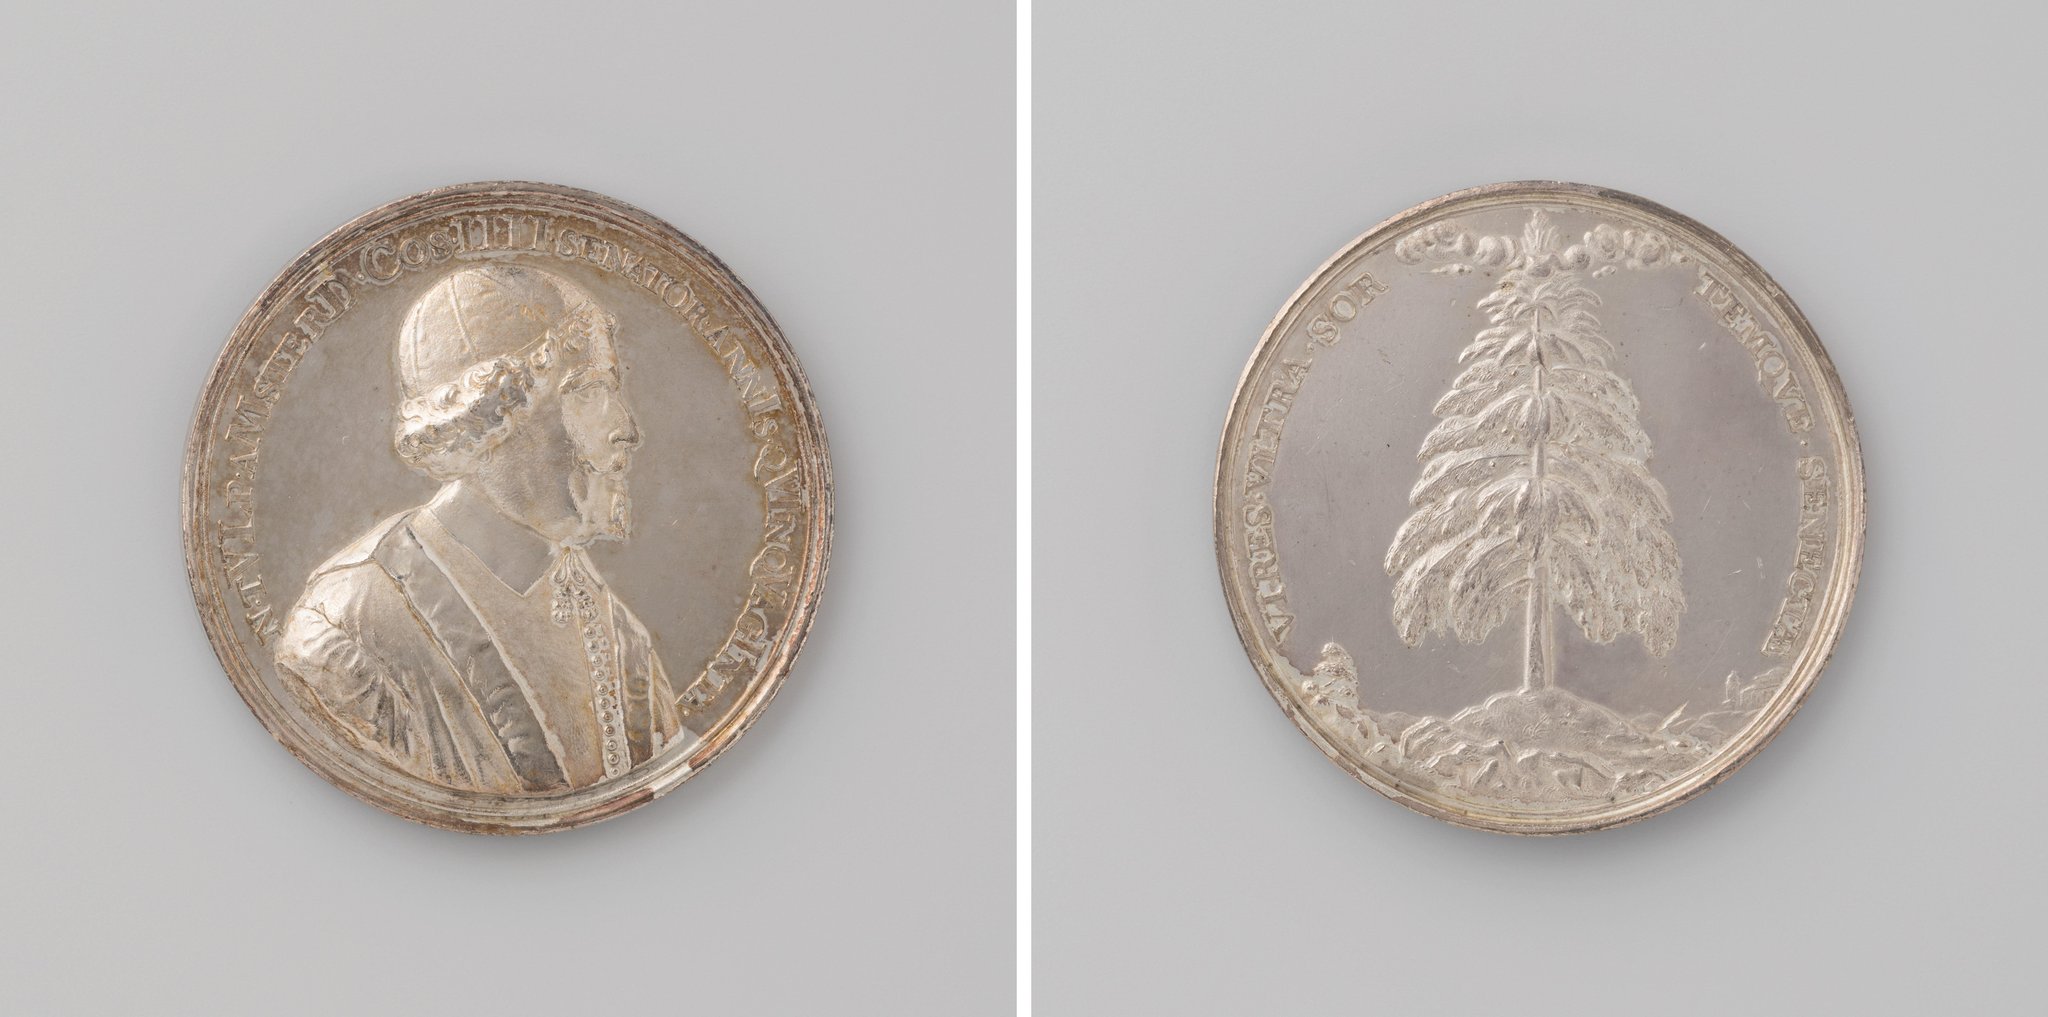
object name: honorary medal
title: Nicolaas Tulp, vier maal burgemeester en vijftig jaar raad van Amsterdam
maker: Anonymous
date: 1672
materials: silver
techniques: striking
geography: netherlands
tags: the hague, amsterdam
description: Zilveren penning. Voorzijde: borststuk man binnen omschrift. Keerzijde: boom met top die in wolken reikt binnen omschrift.